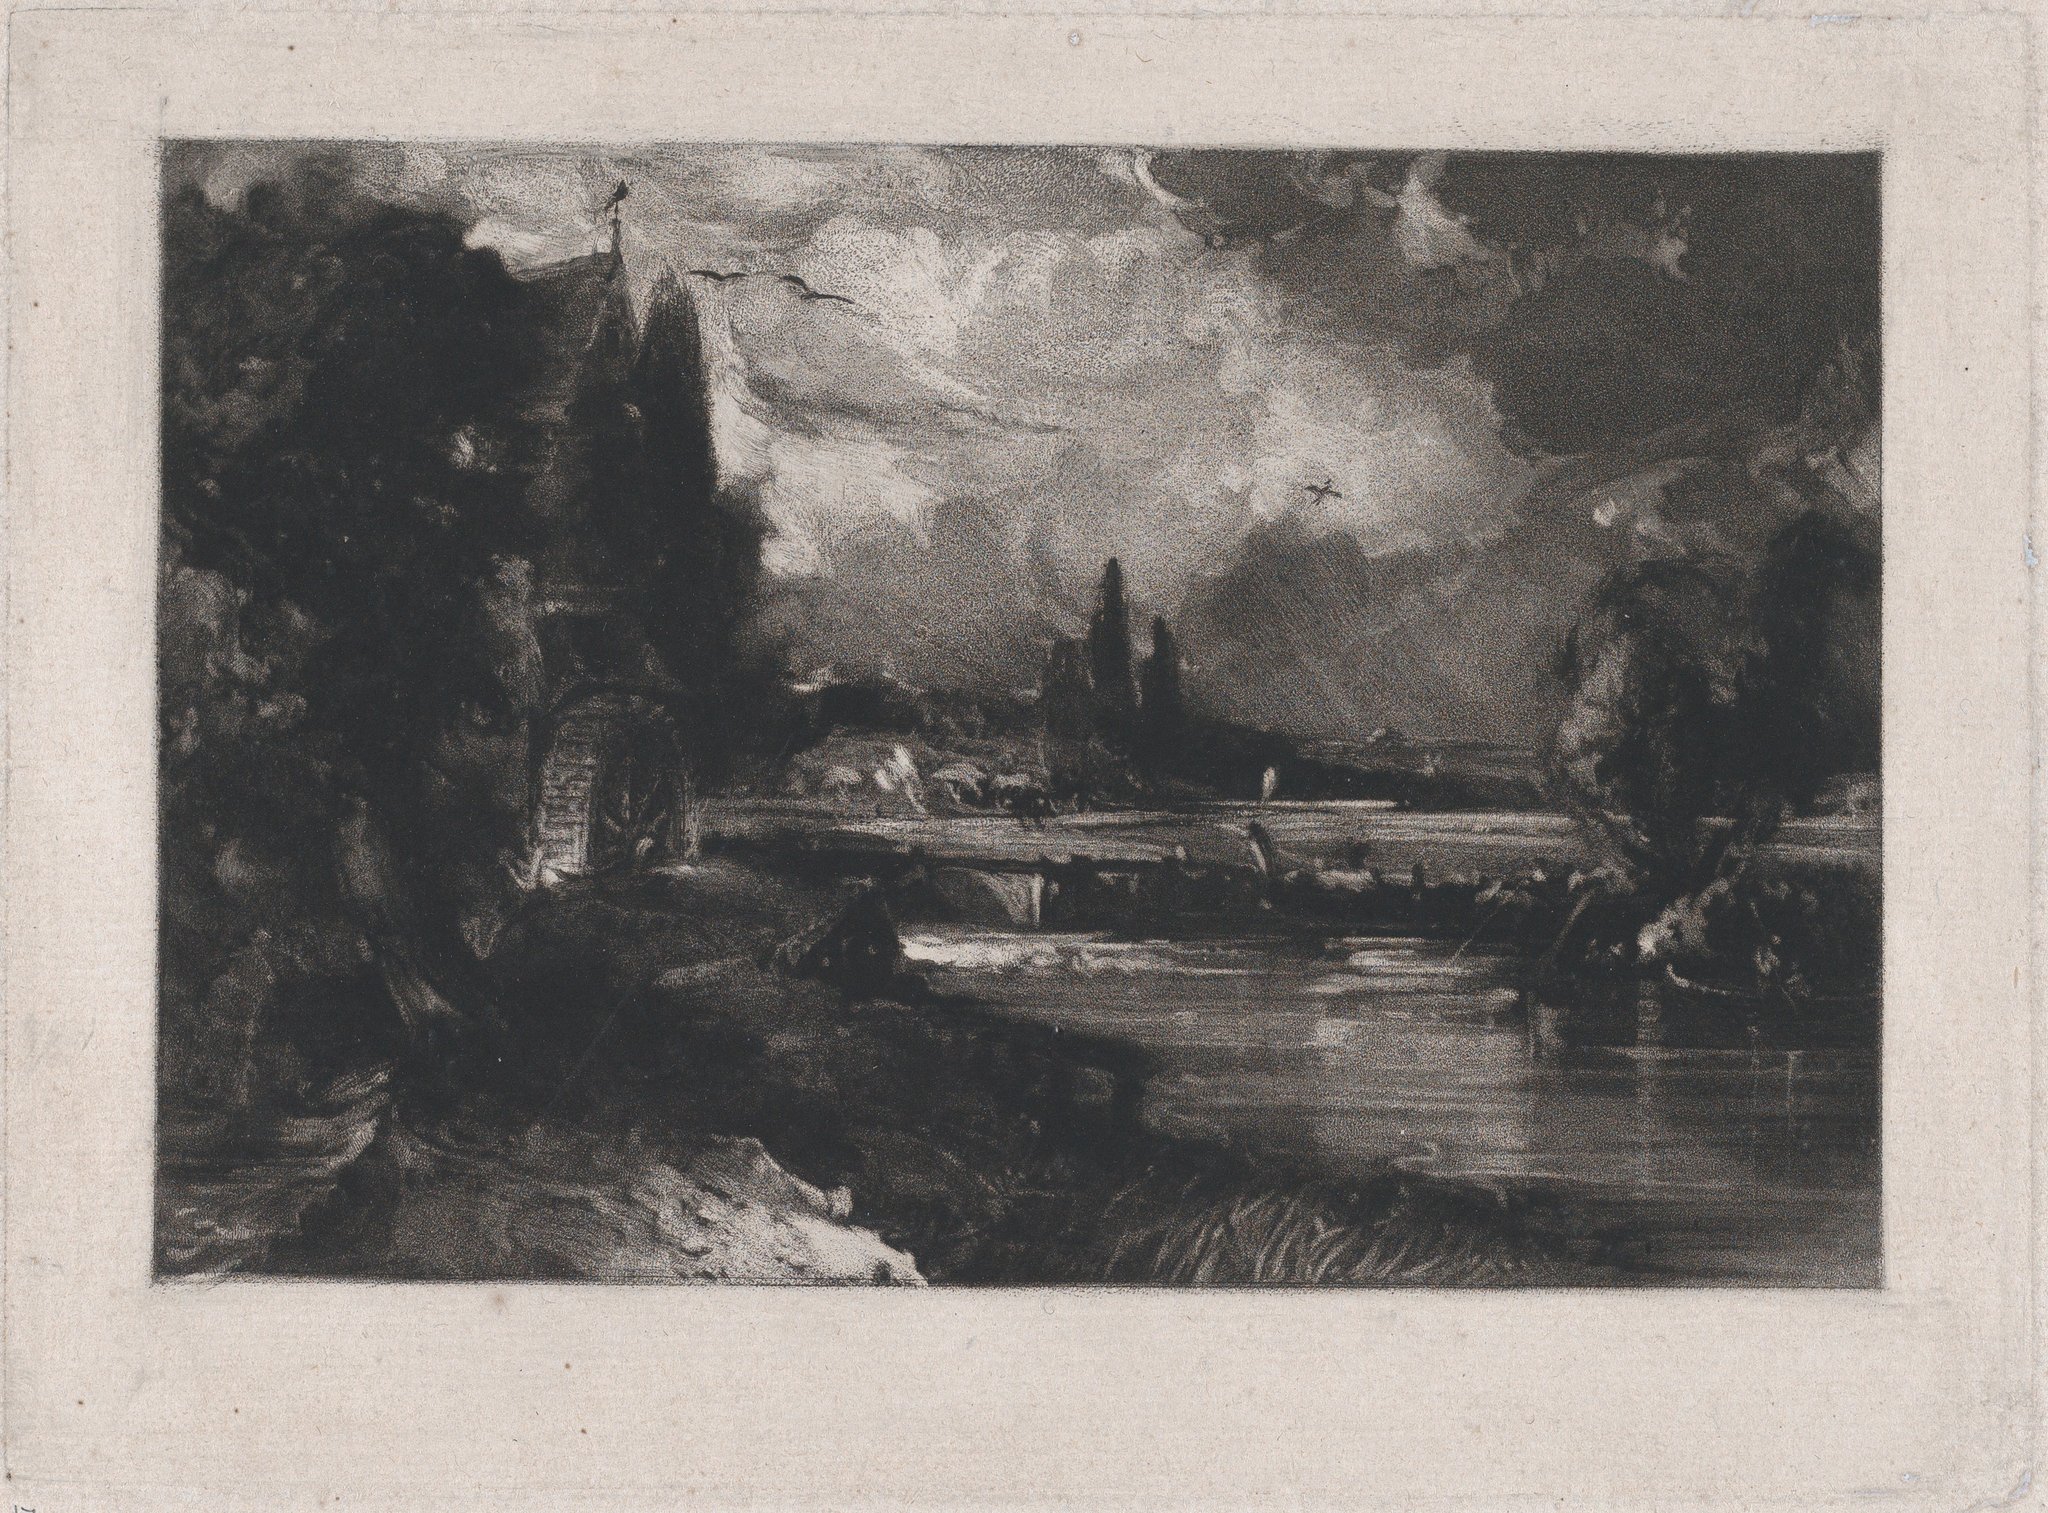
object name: print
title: A Mill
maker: david lucas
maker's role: artist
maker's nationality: british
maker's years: 1802-1881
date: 1829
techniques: mezzotint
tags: watermills,landscapes